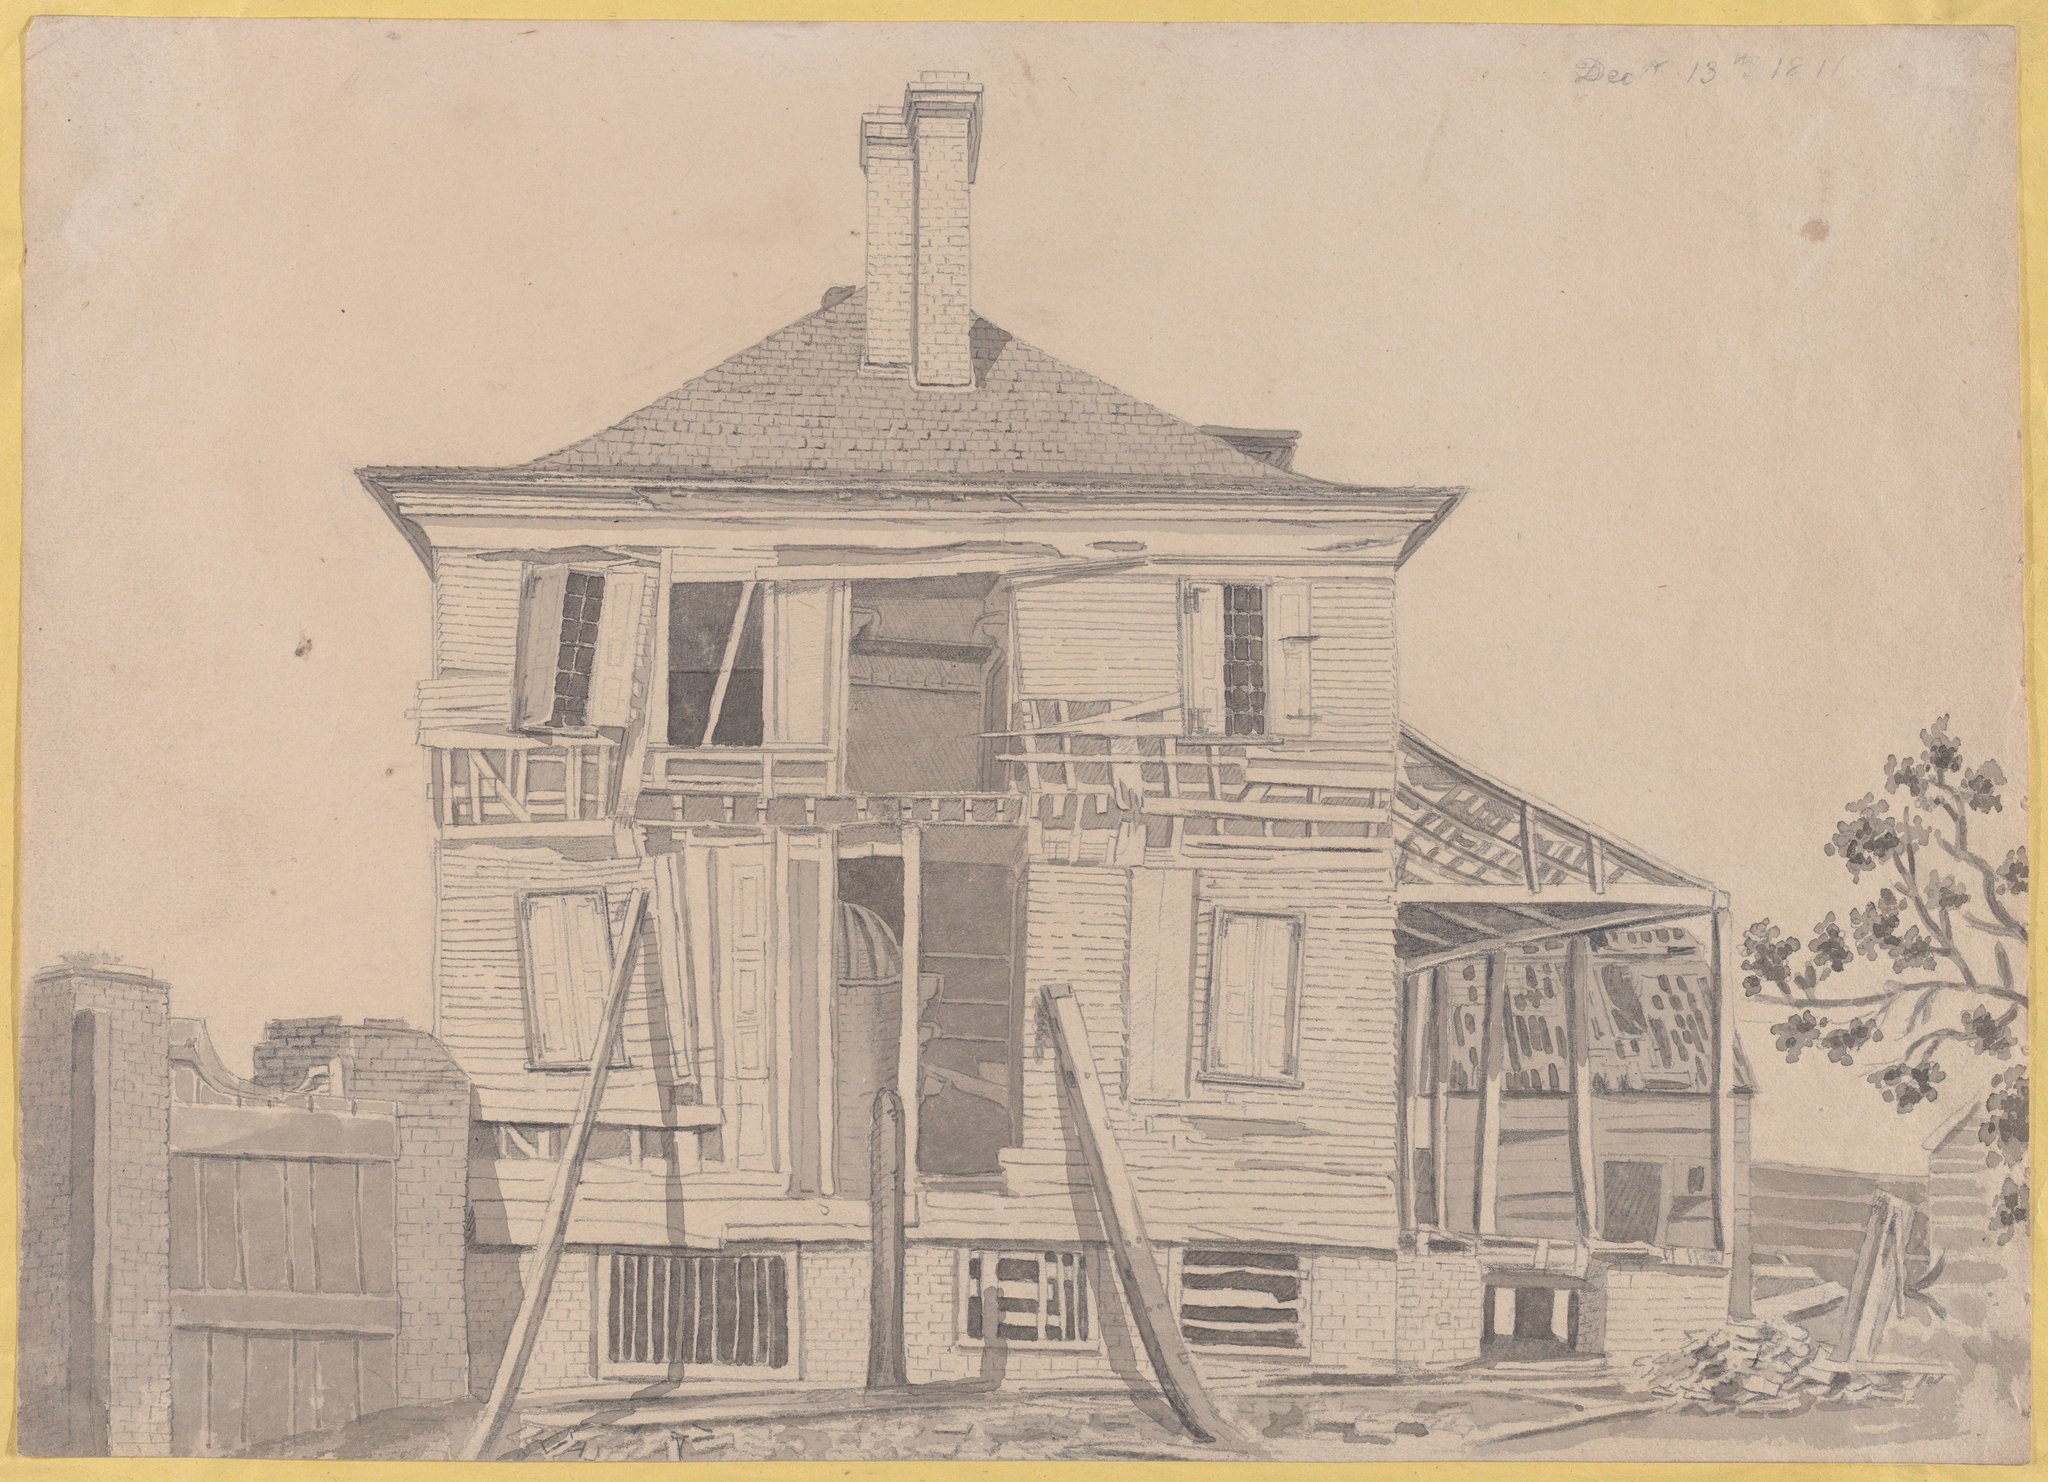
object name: drawing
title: Dilapidated House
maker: anonymous, american, 19th century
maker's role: artist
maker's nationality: american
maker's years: 1800-1900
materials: graphite, ink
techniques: wash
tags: houses